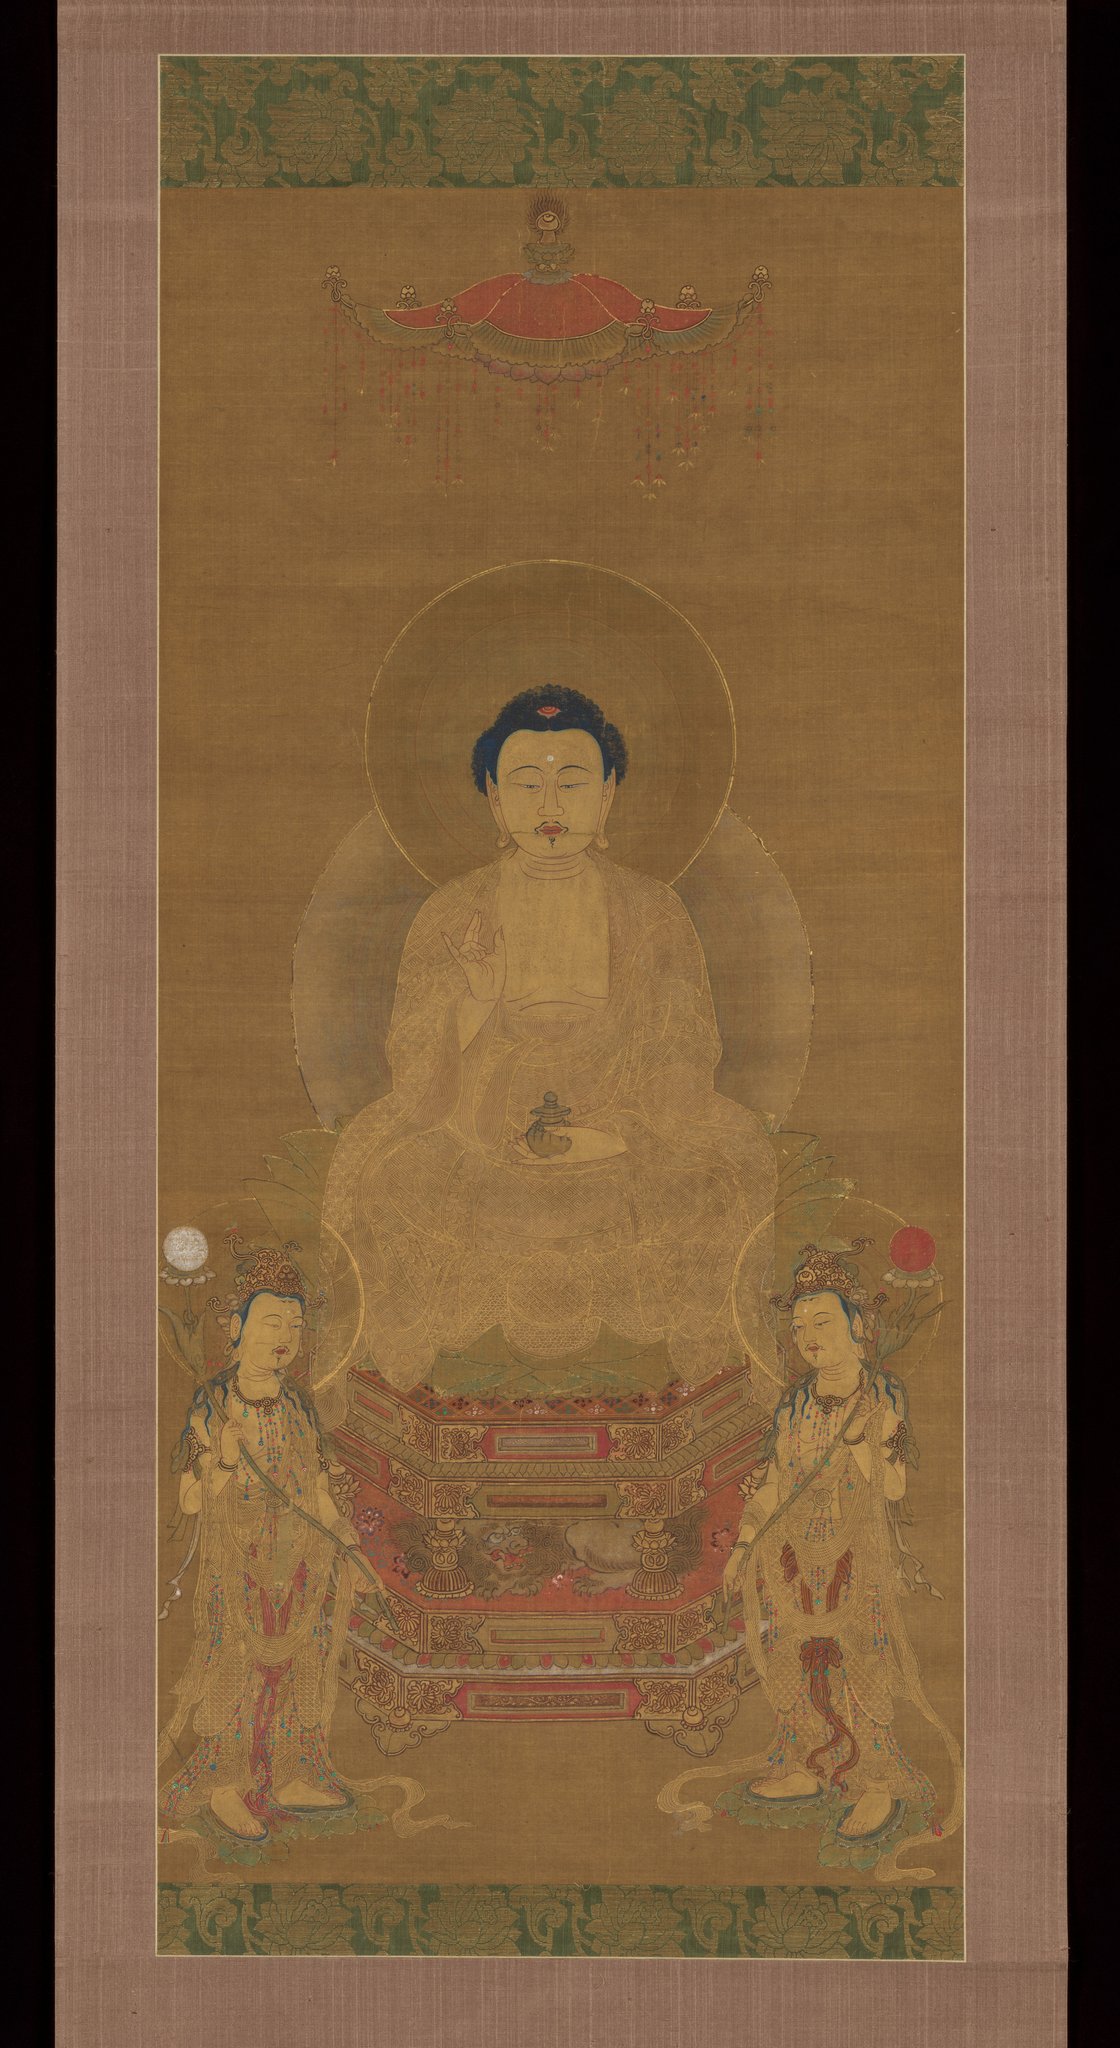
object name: hanging scroll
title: Triad of the Medicine Master Buddha Yakushi (Bhaisajya Buddha)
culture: japanese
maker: unidentified artist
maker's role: artist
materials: ink, paint, silk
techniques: cutting, kirikane